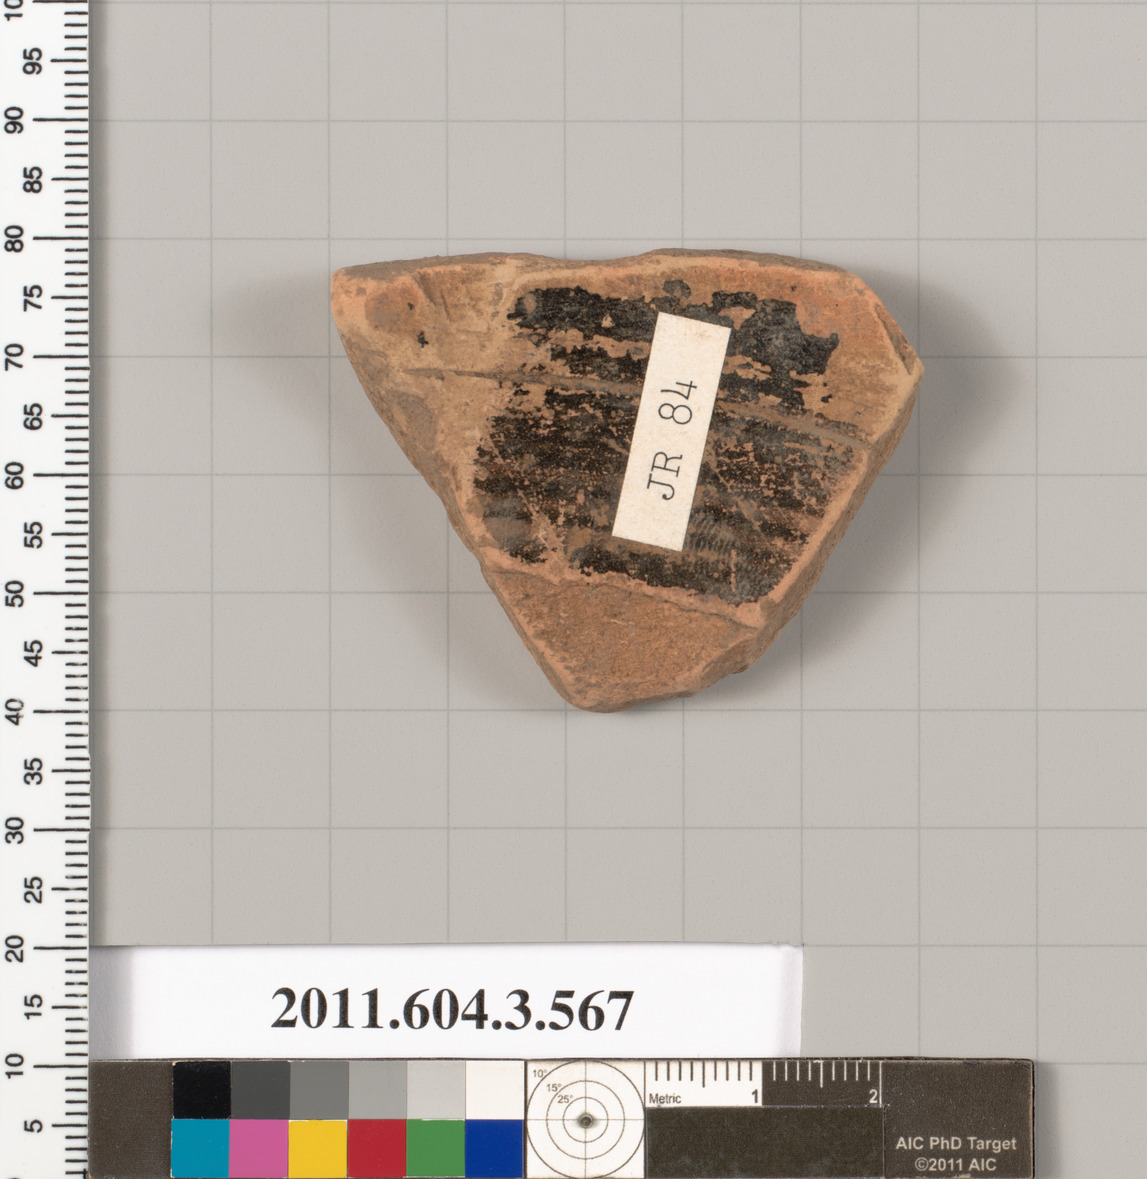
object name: column krater fragment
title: Terracotta fragment of a column-krater (bowl for mixing wine and water)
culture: greek, attic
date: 600-401 BCE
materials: terracotta